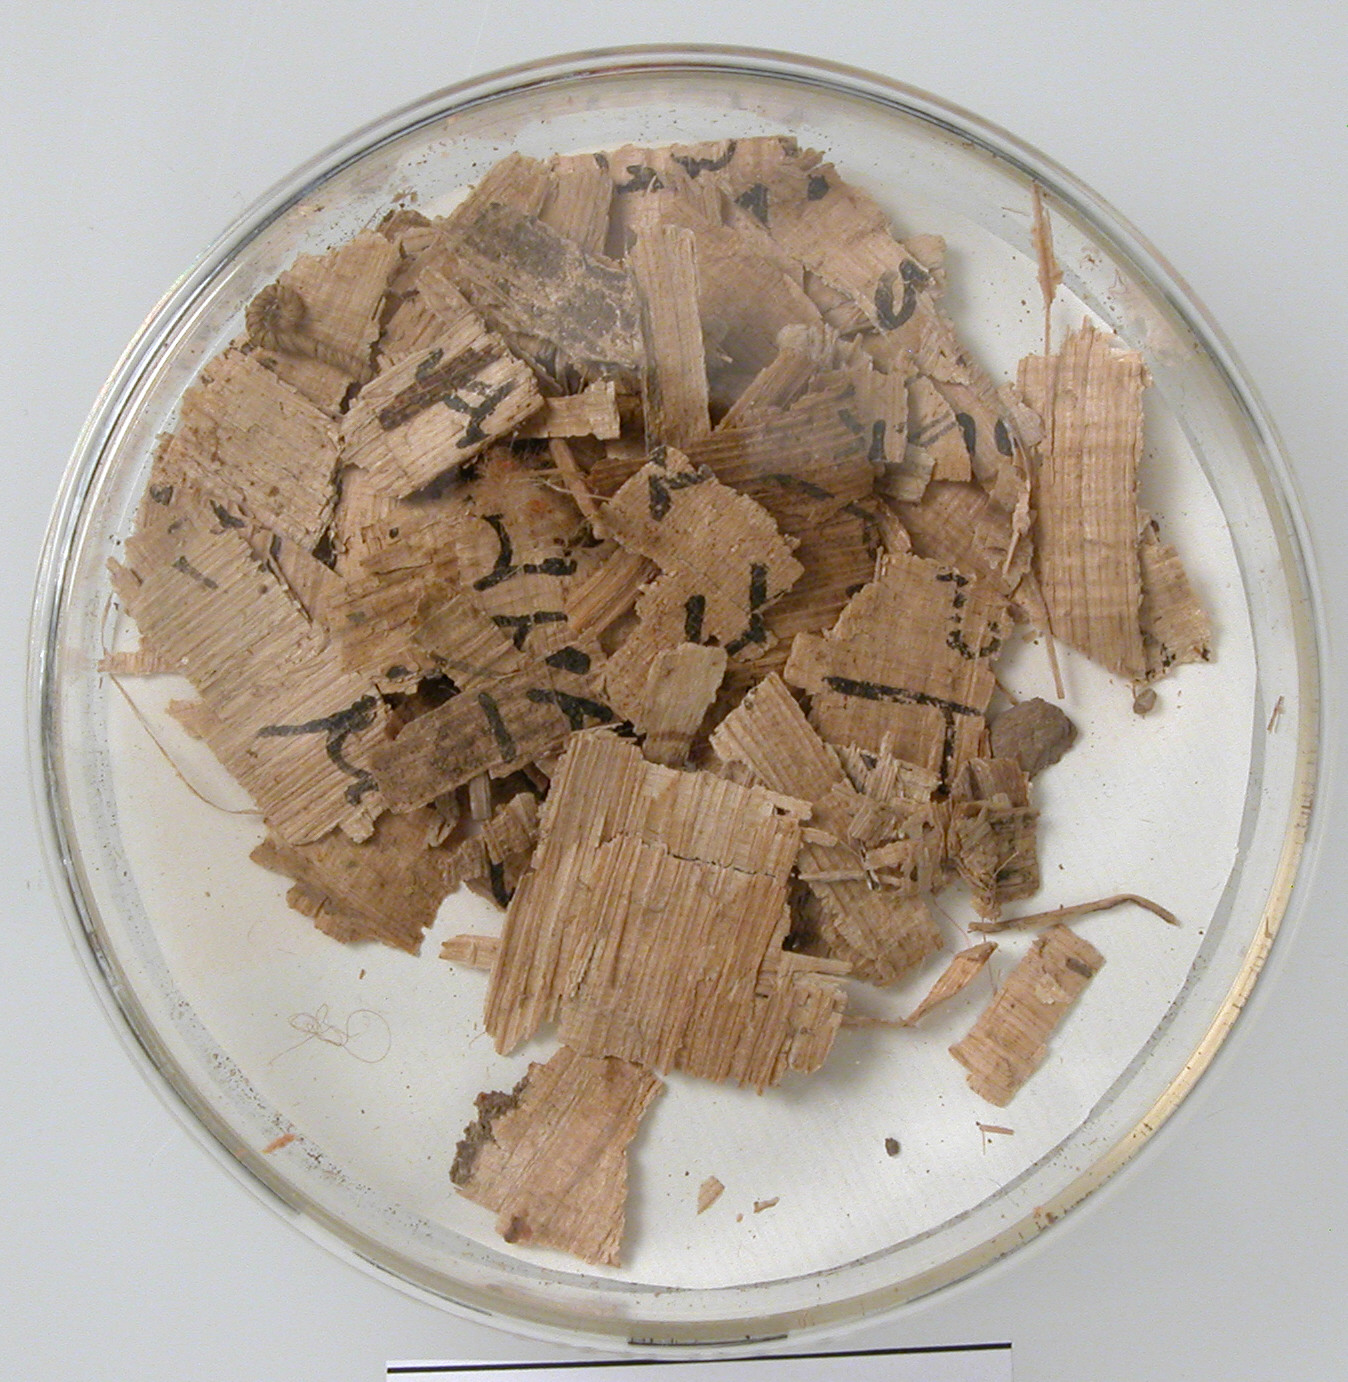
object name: fragment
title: Papyri Fragments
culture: coptic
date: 601-700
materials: ink, papyrus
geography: egypt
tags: documents